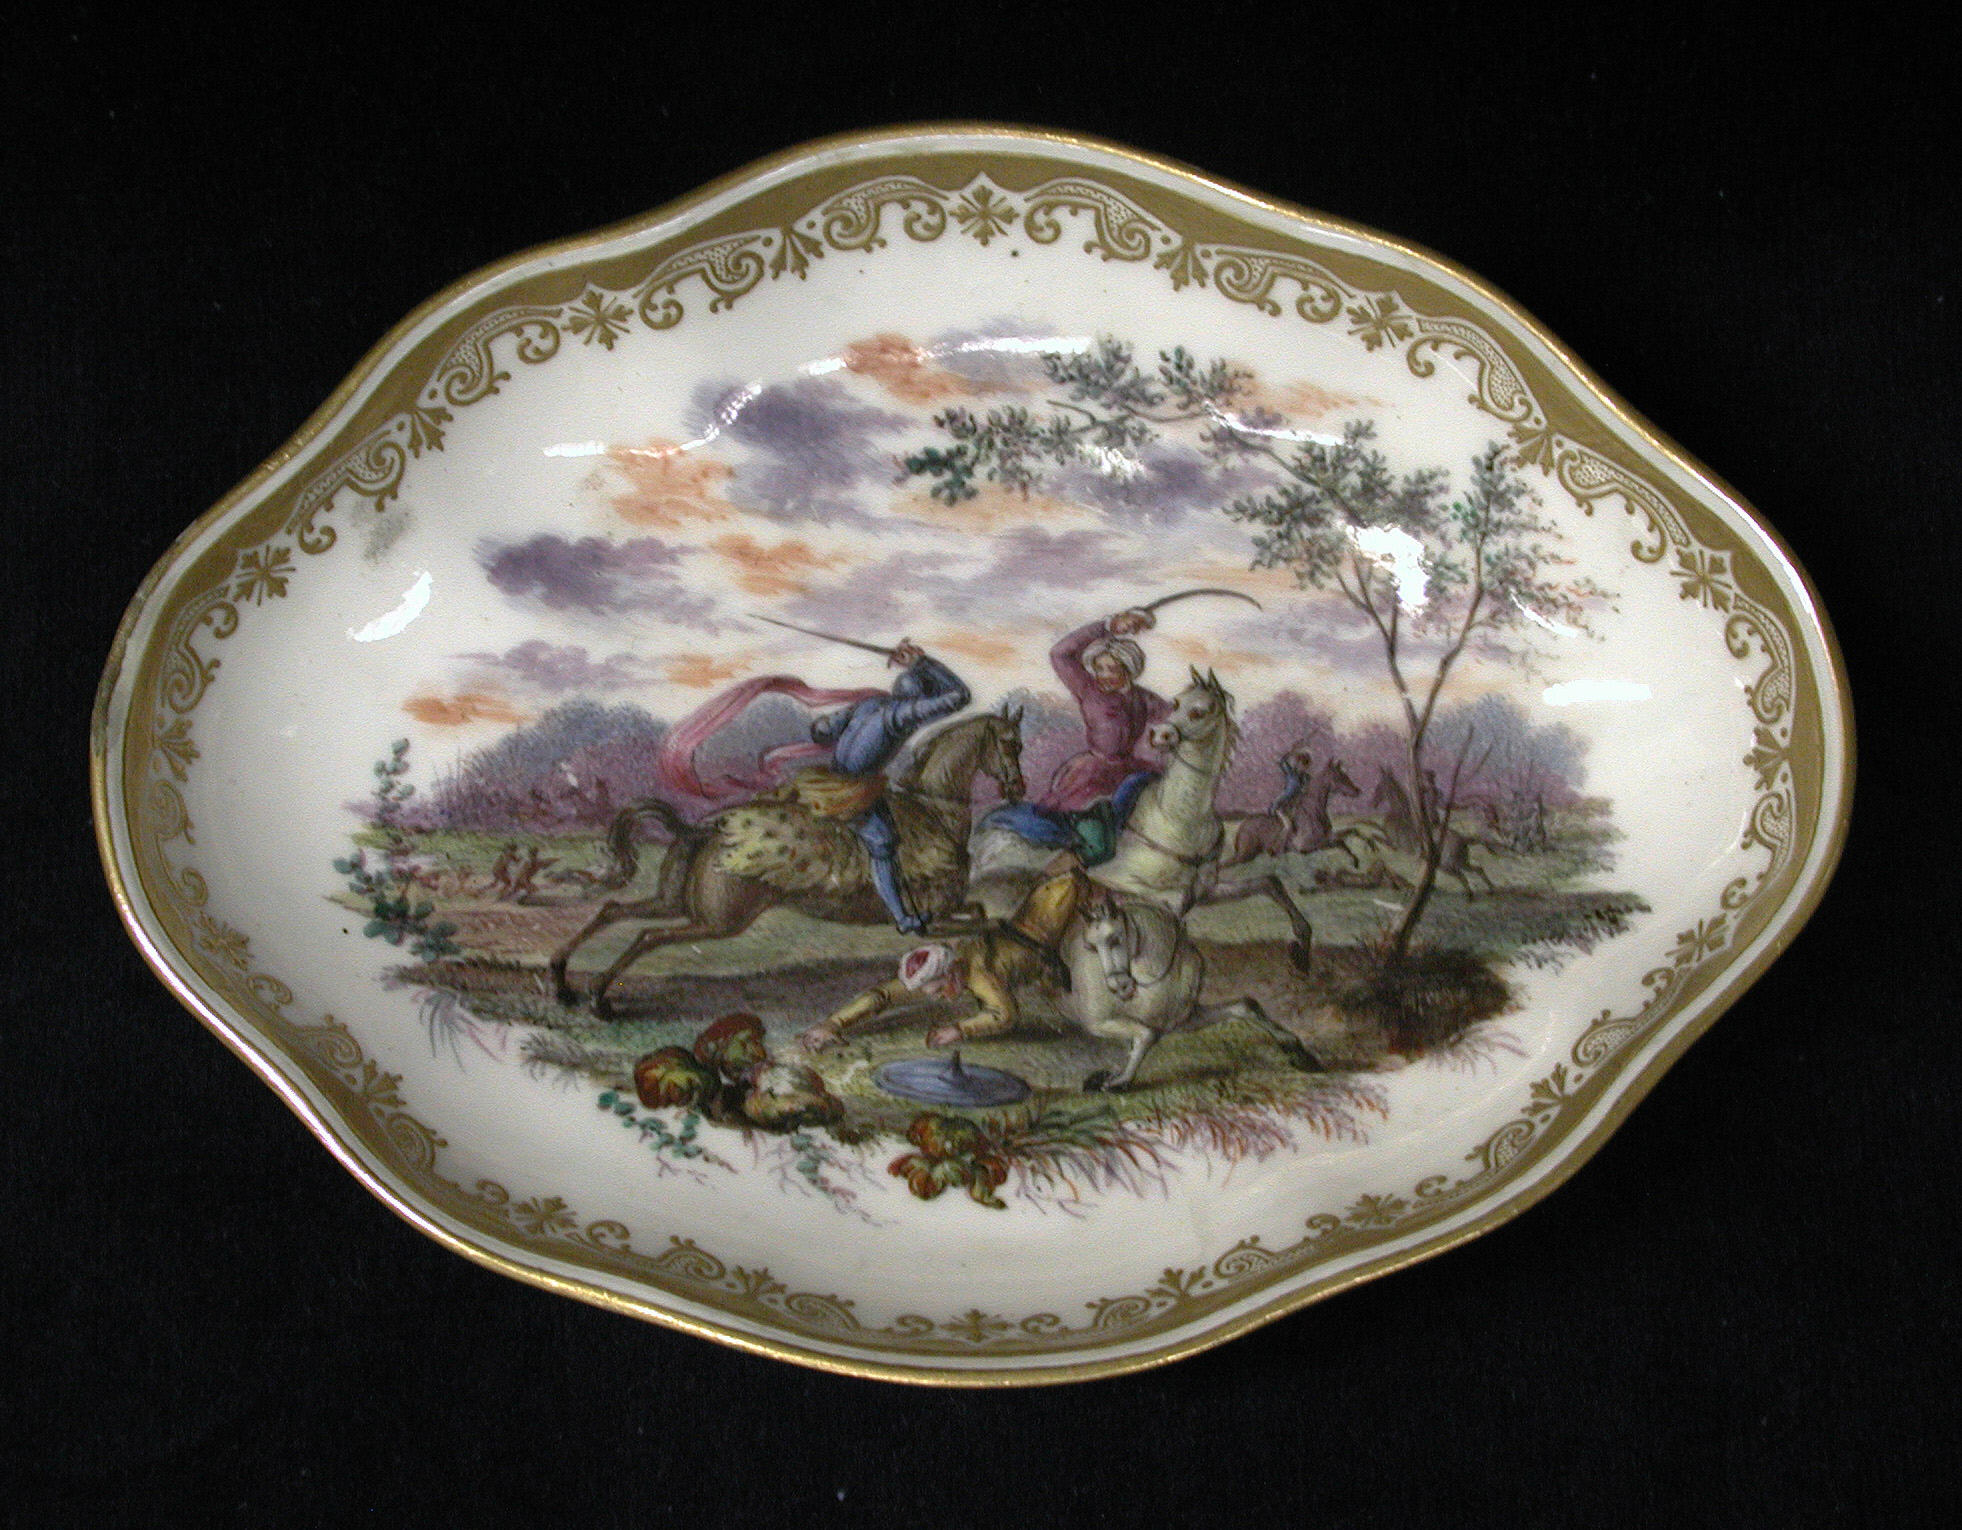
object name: tray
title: Oval tray (part of a service)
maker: capodimonte porcelain manufactory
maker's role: manufactory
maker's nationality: italian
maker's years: 1740-1759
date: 1743-1759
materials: soft paste porcelain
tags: battles,swords,men,horses